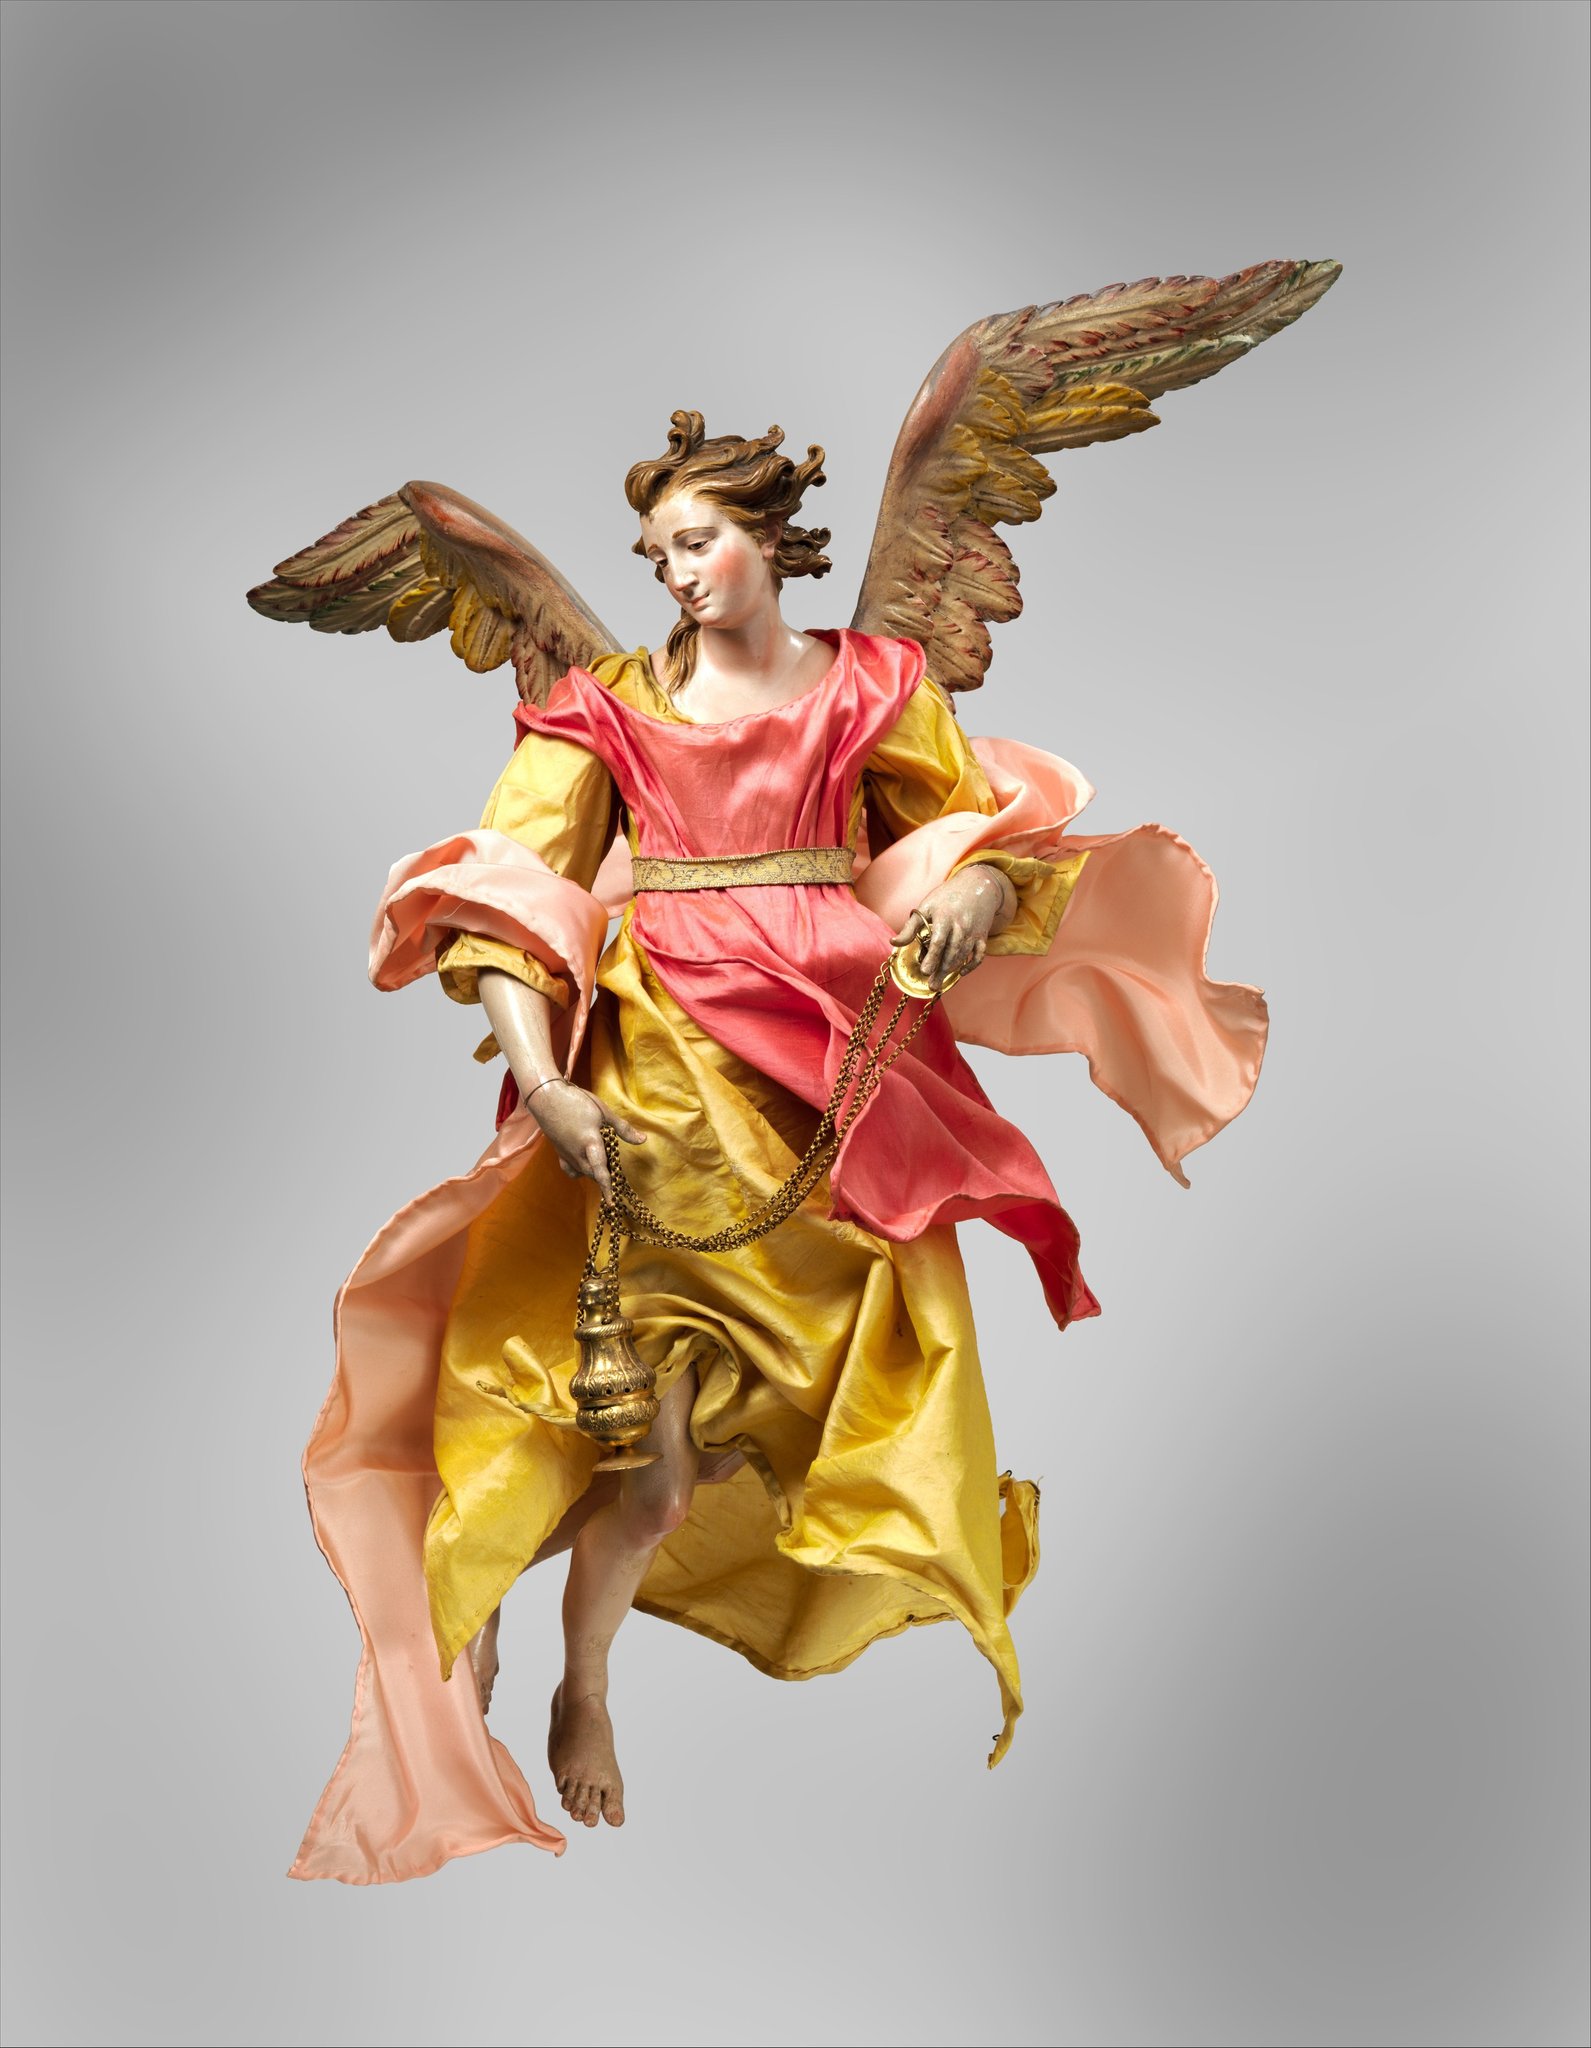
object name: crèche figure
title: Angel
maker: giuseppe sanmartino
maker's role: maker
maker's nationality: italian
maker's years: 1720-1793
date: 1751-1800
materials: terracotta, fiber, metal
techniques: polychrome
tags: angels